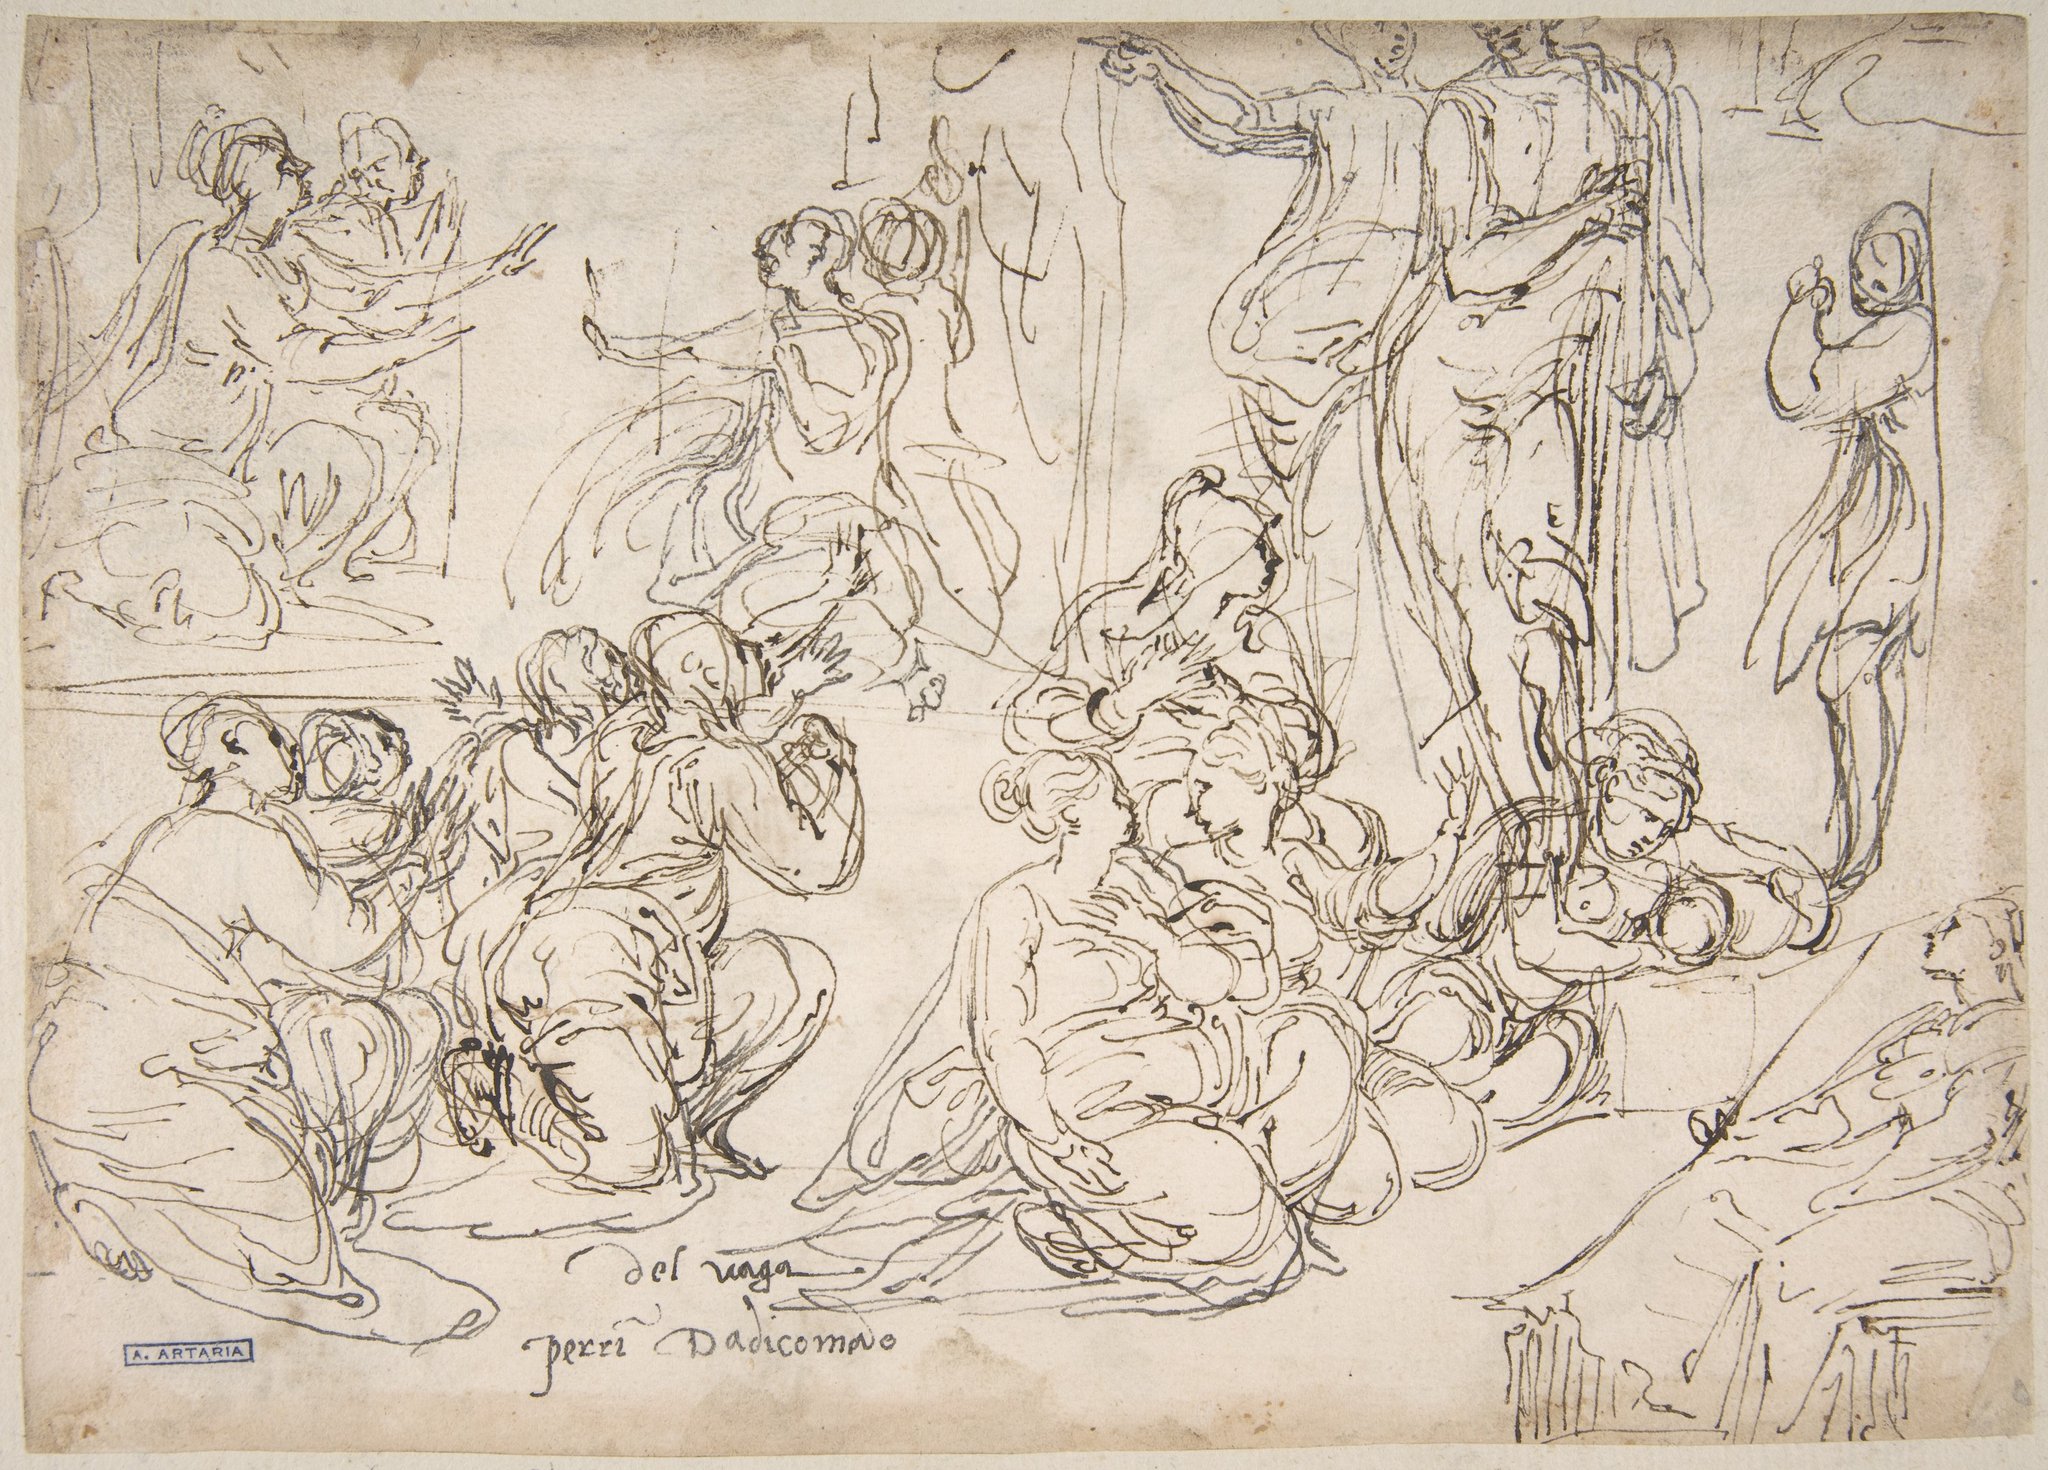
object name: drawing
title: Kneeling, Seated and Standing Figures (recto); Seated, Kneeling and Reclining Figures (verso)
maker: perino del vaga (pietro buonaccorsi)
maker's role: artist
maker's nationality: italian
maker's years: 1501-1547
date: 1501-1547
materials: ink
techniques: pen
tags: men,women